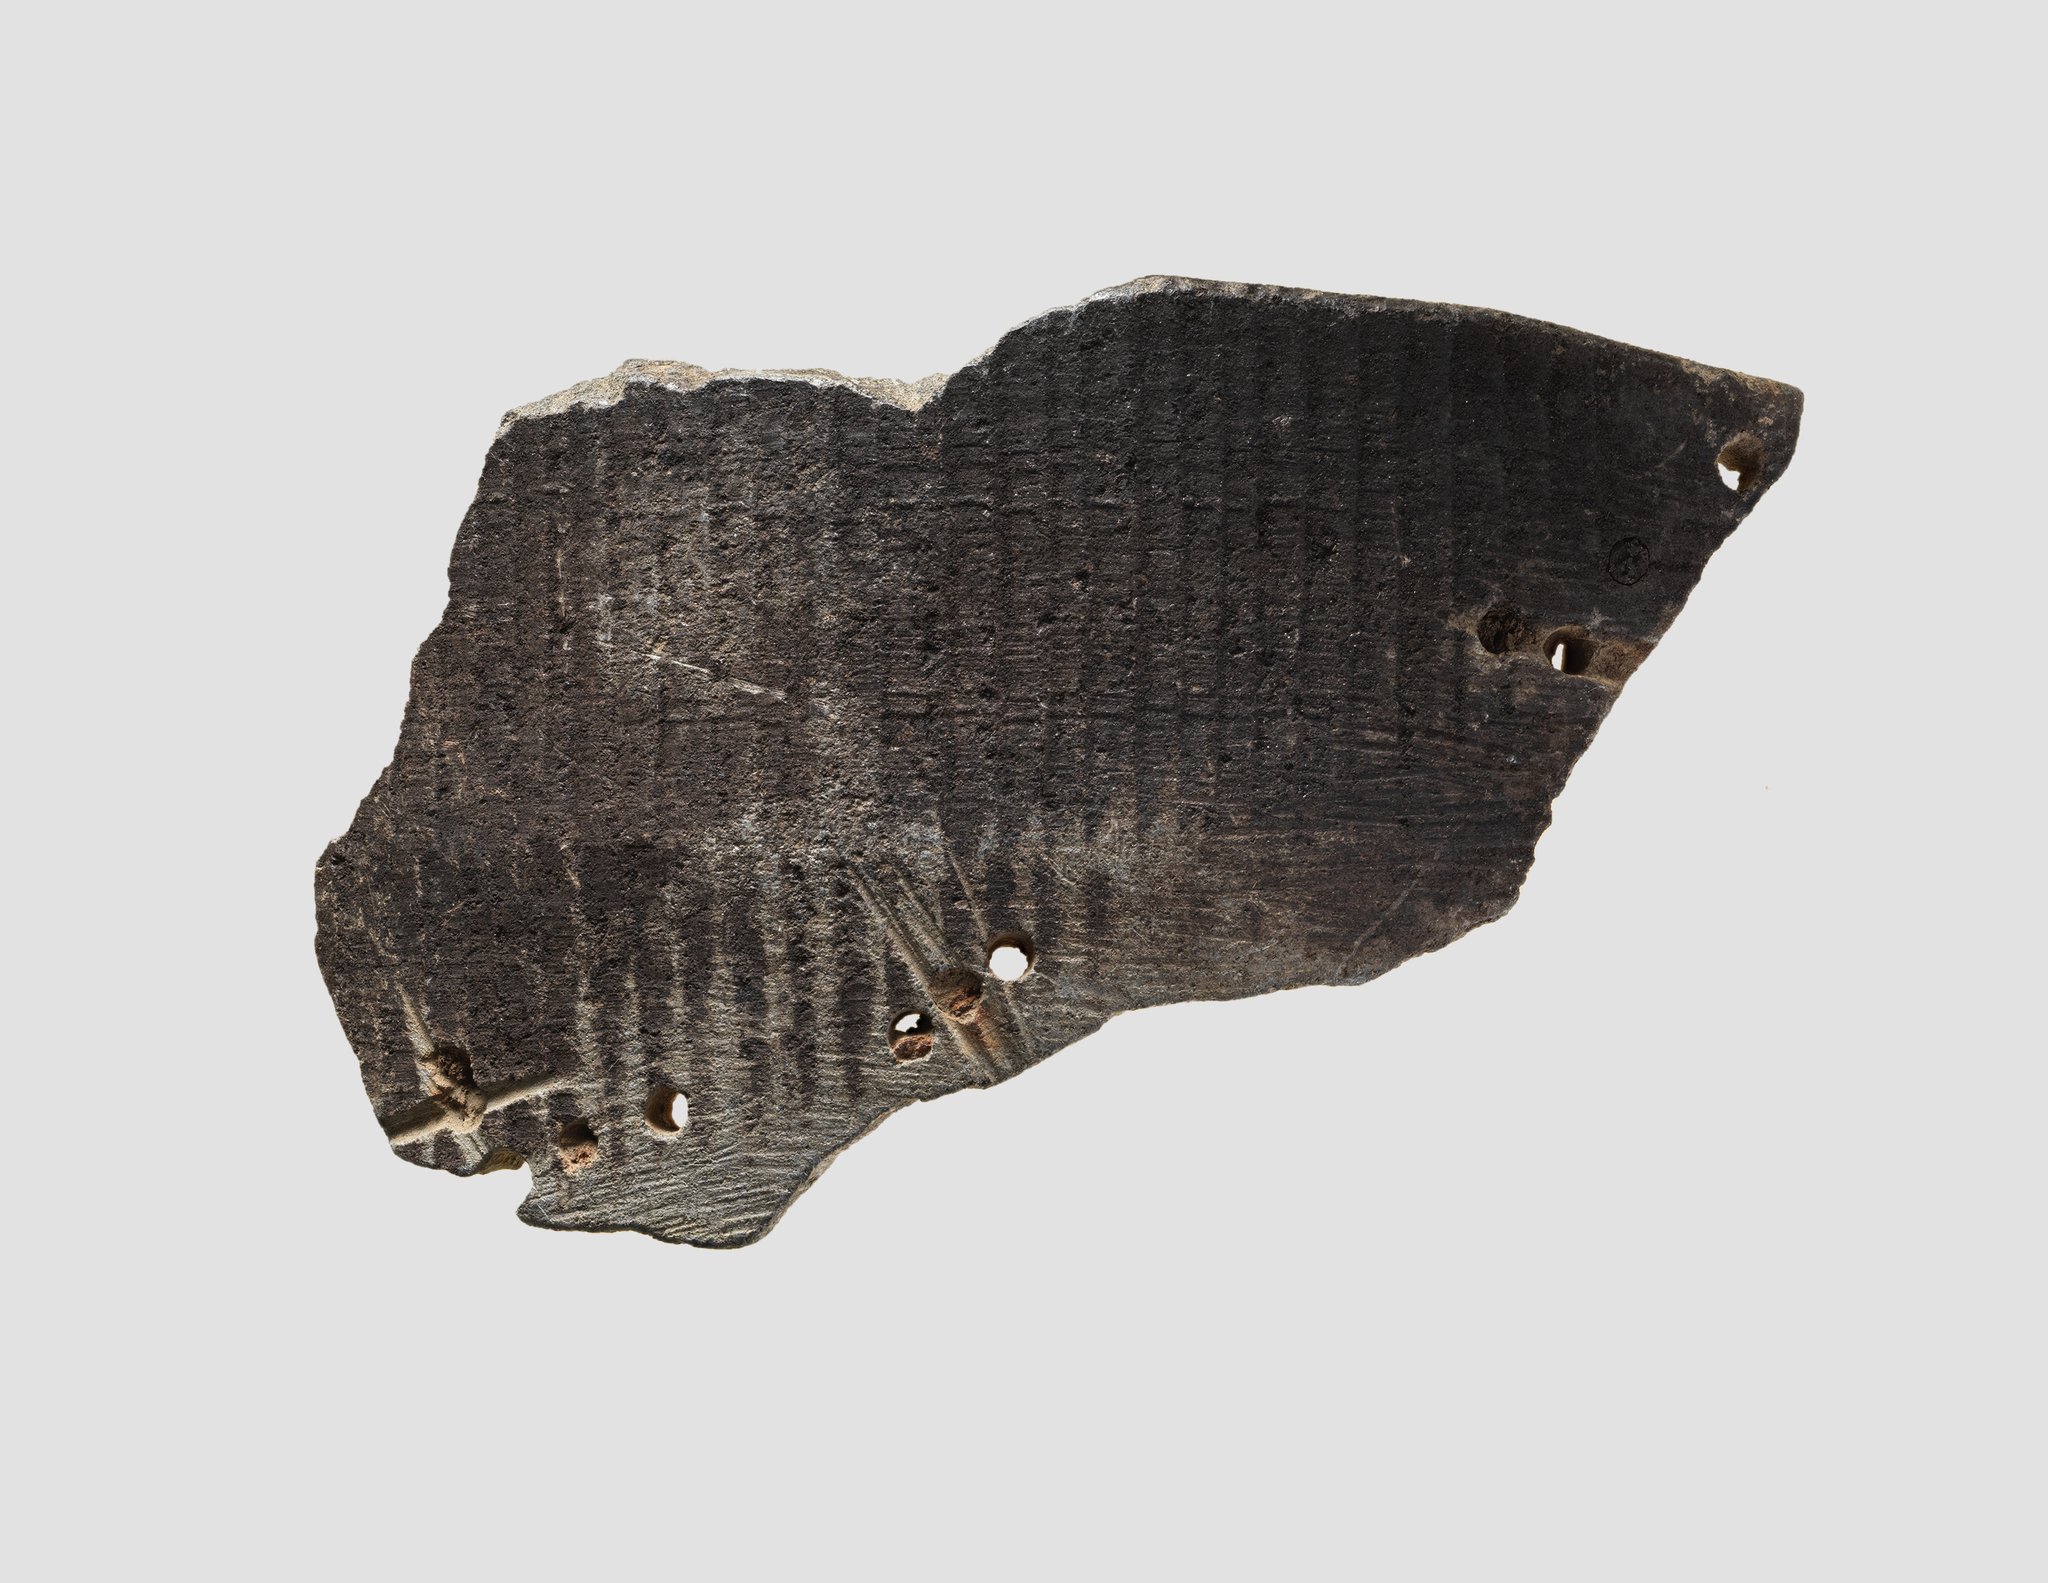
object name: vessel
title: Stone vessel fragment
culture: sasanian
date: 201-700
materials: stone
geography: mesopotamia